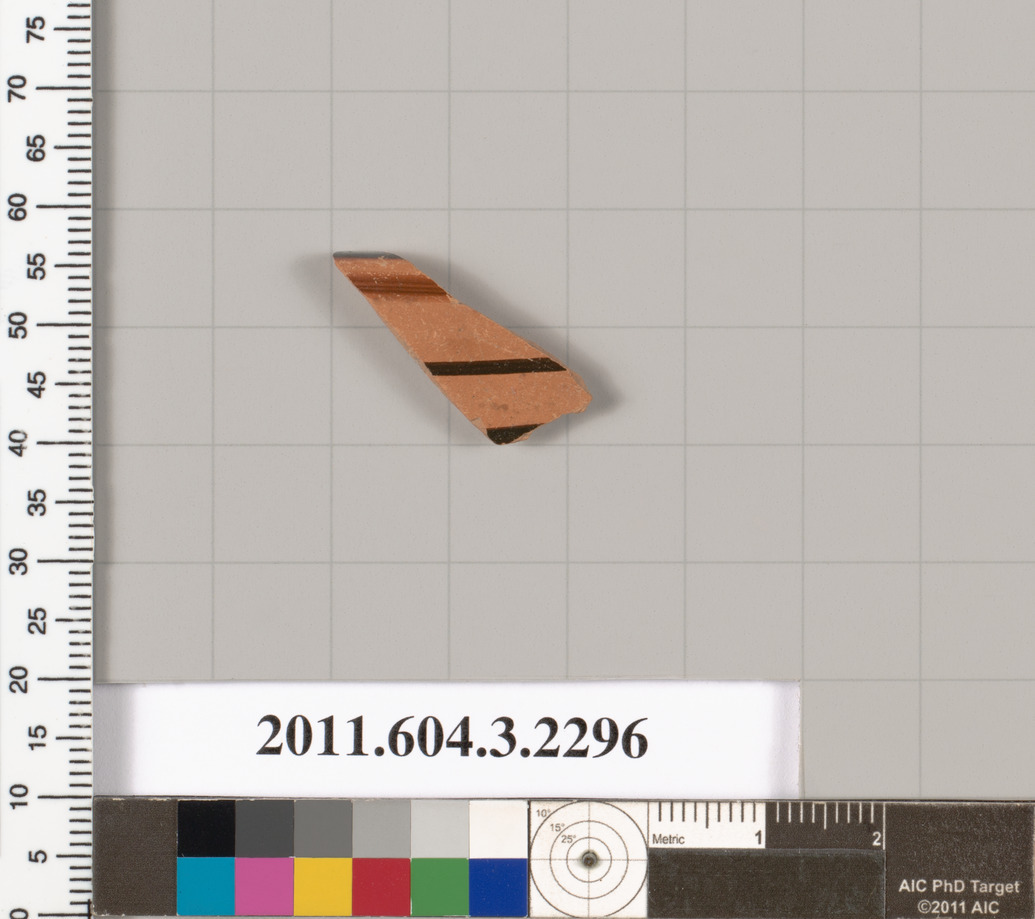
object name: kylix fragment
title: Terracotta rim fragment of a kylix: eye-cup (drinking cup)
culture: greek, attic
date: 540-500 BCE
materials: terracotta